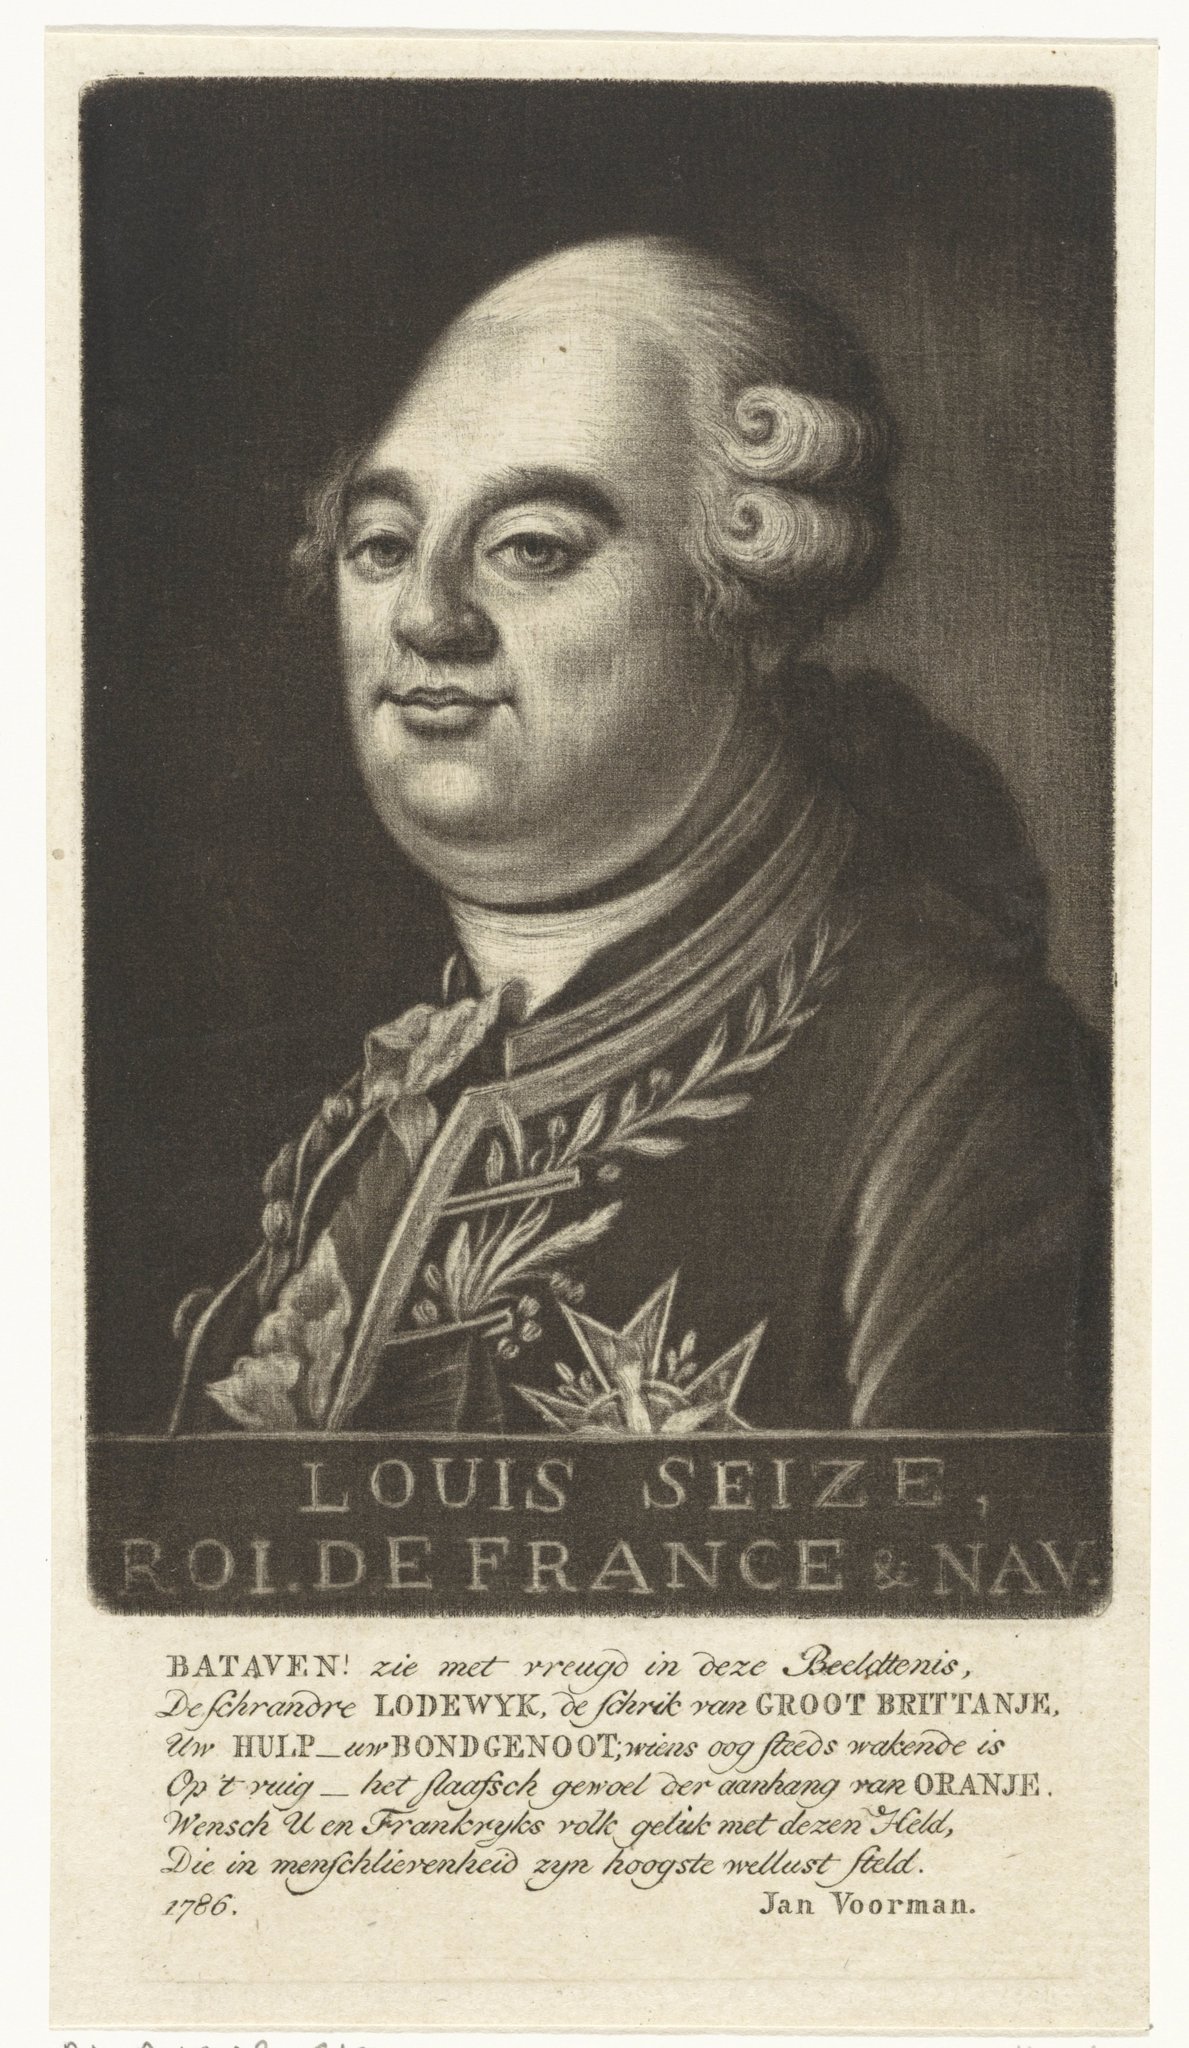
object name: print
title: Portret van Lodewijk XVI, koning van Frankrijk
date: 1786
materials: paper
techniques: engraving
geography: leeuwarden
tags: paris, lodewijk xvi (koning van frankrijk)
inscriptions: collector's mark: Lugt 2228